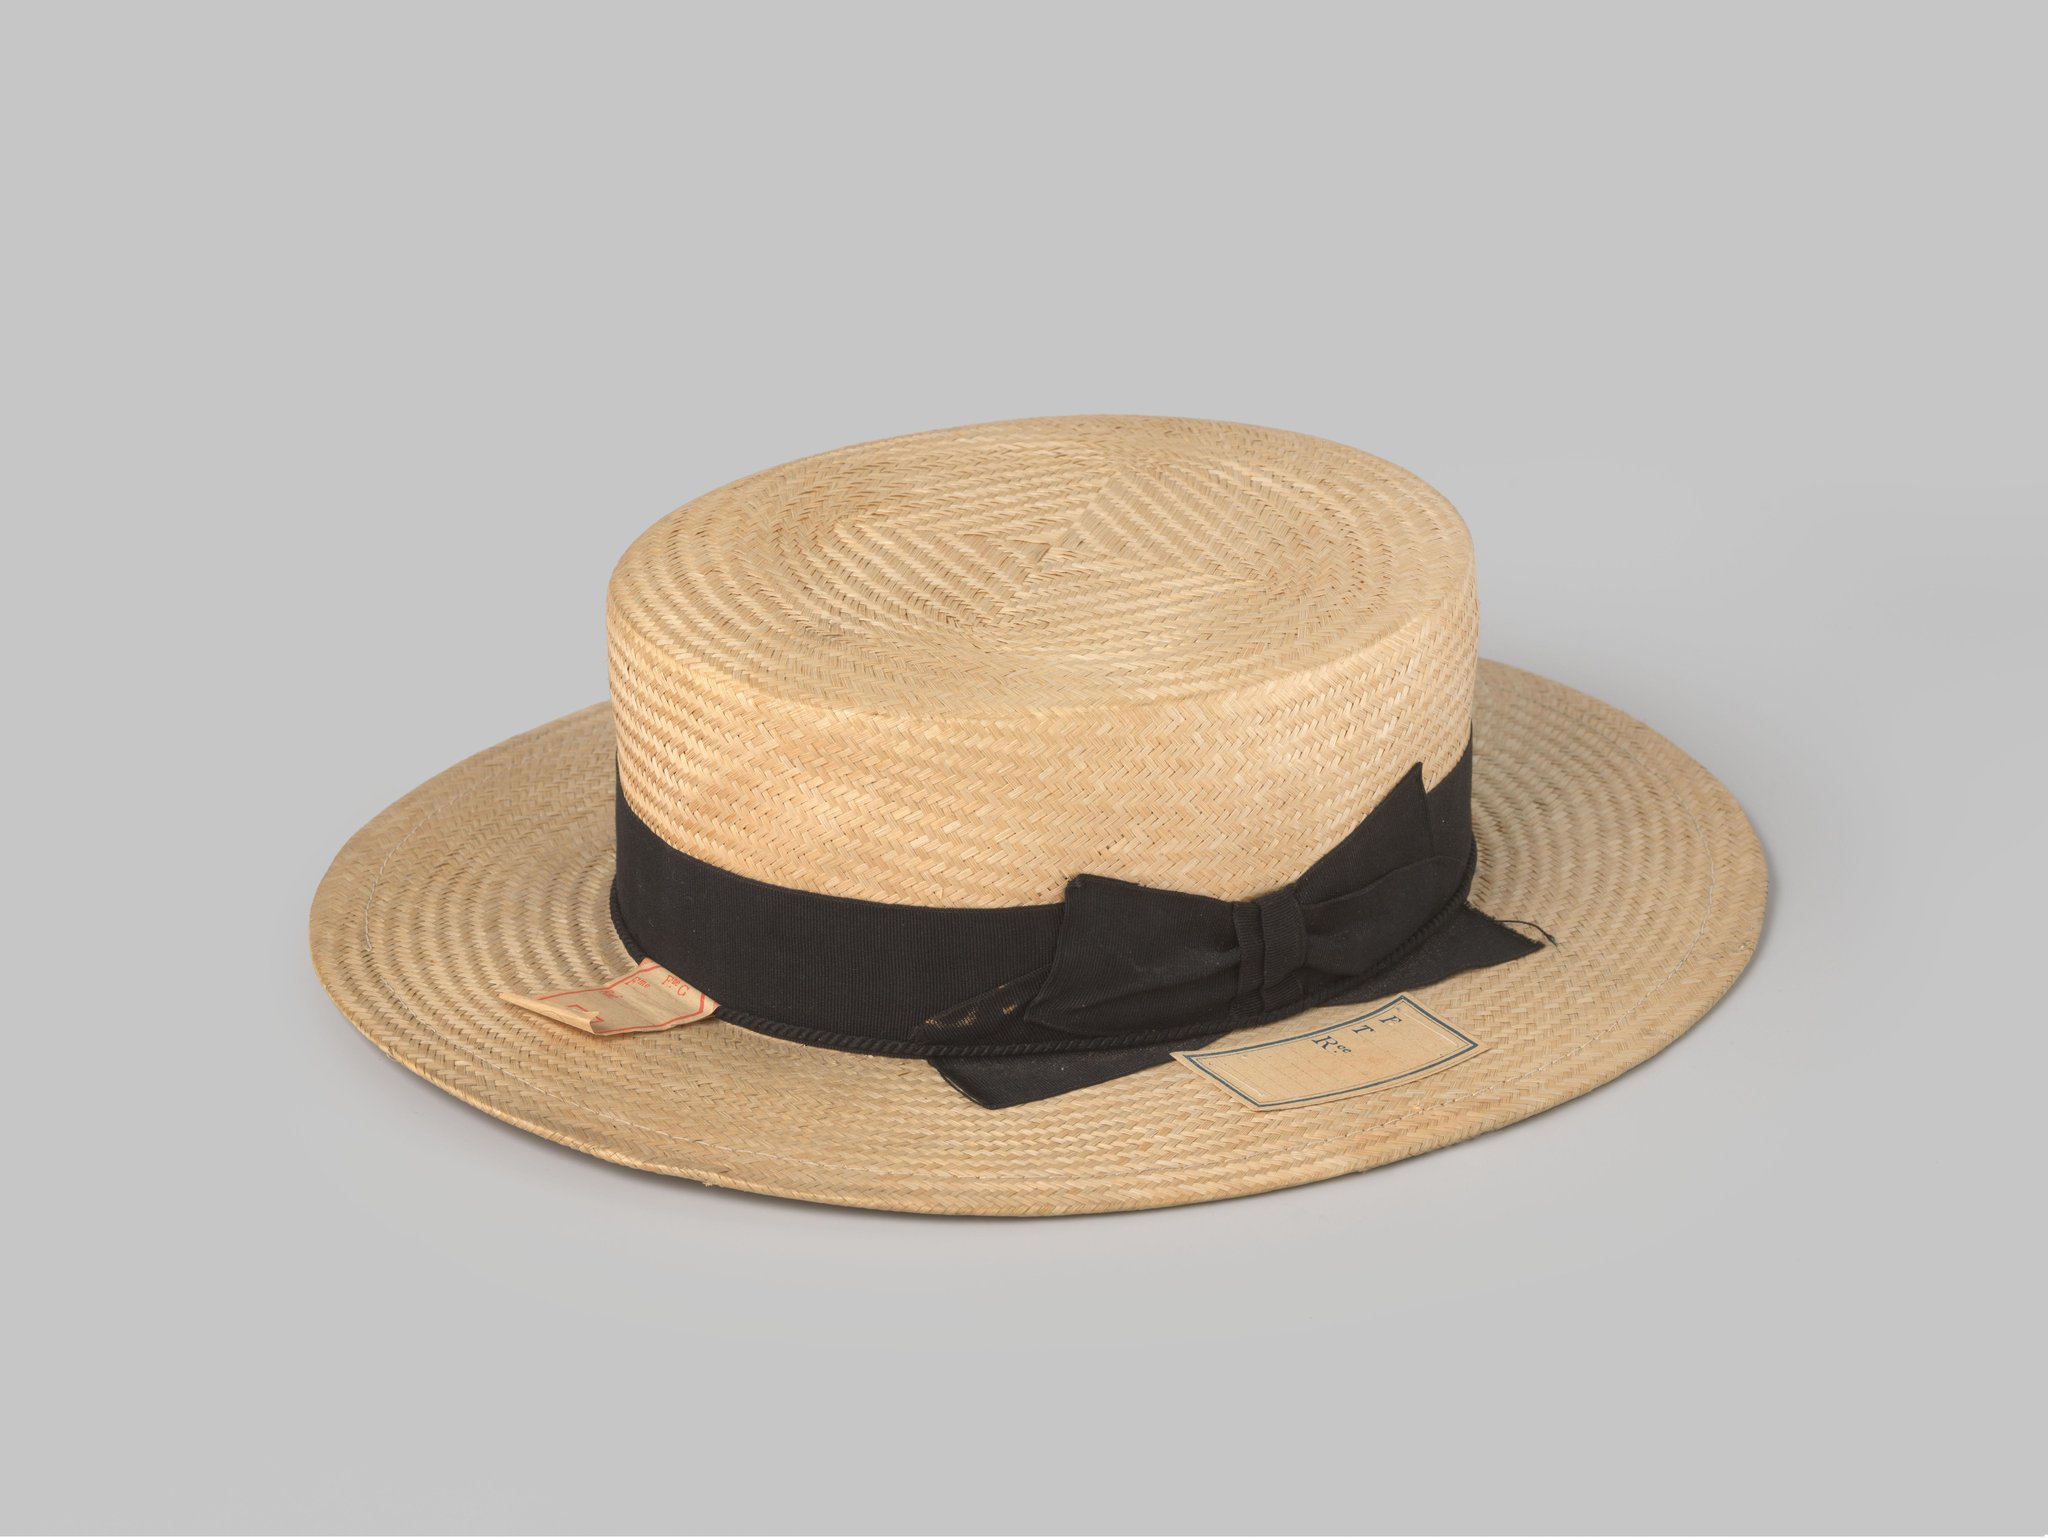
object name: zomerhoed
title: Hoed van naturel kleurig gevlochten stro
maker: Anonymous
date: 1920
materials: ribbon, straw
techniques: braiding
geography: france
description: Zomerhoed van naturelkleurig gevlochten stro, met zwart lint in platte strik. Ovaal, plat. Adres: MARQUE DEPOSE en wapen, I.3. II. F T Ree.